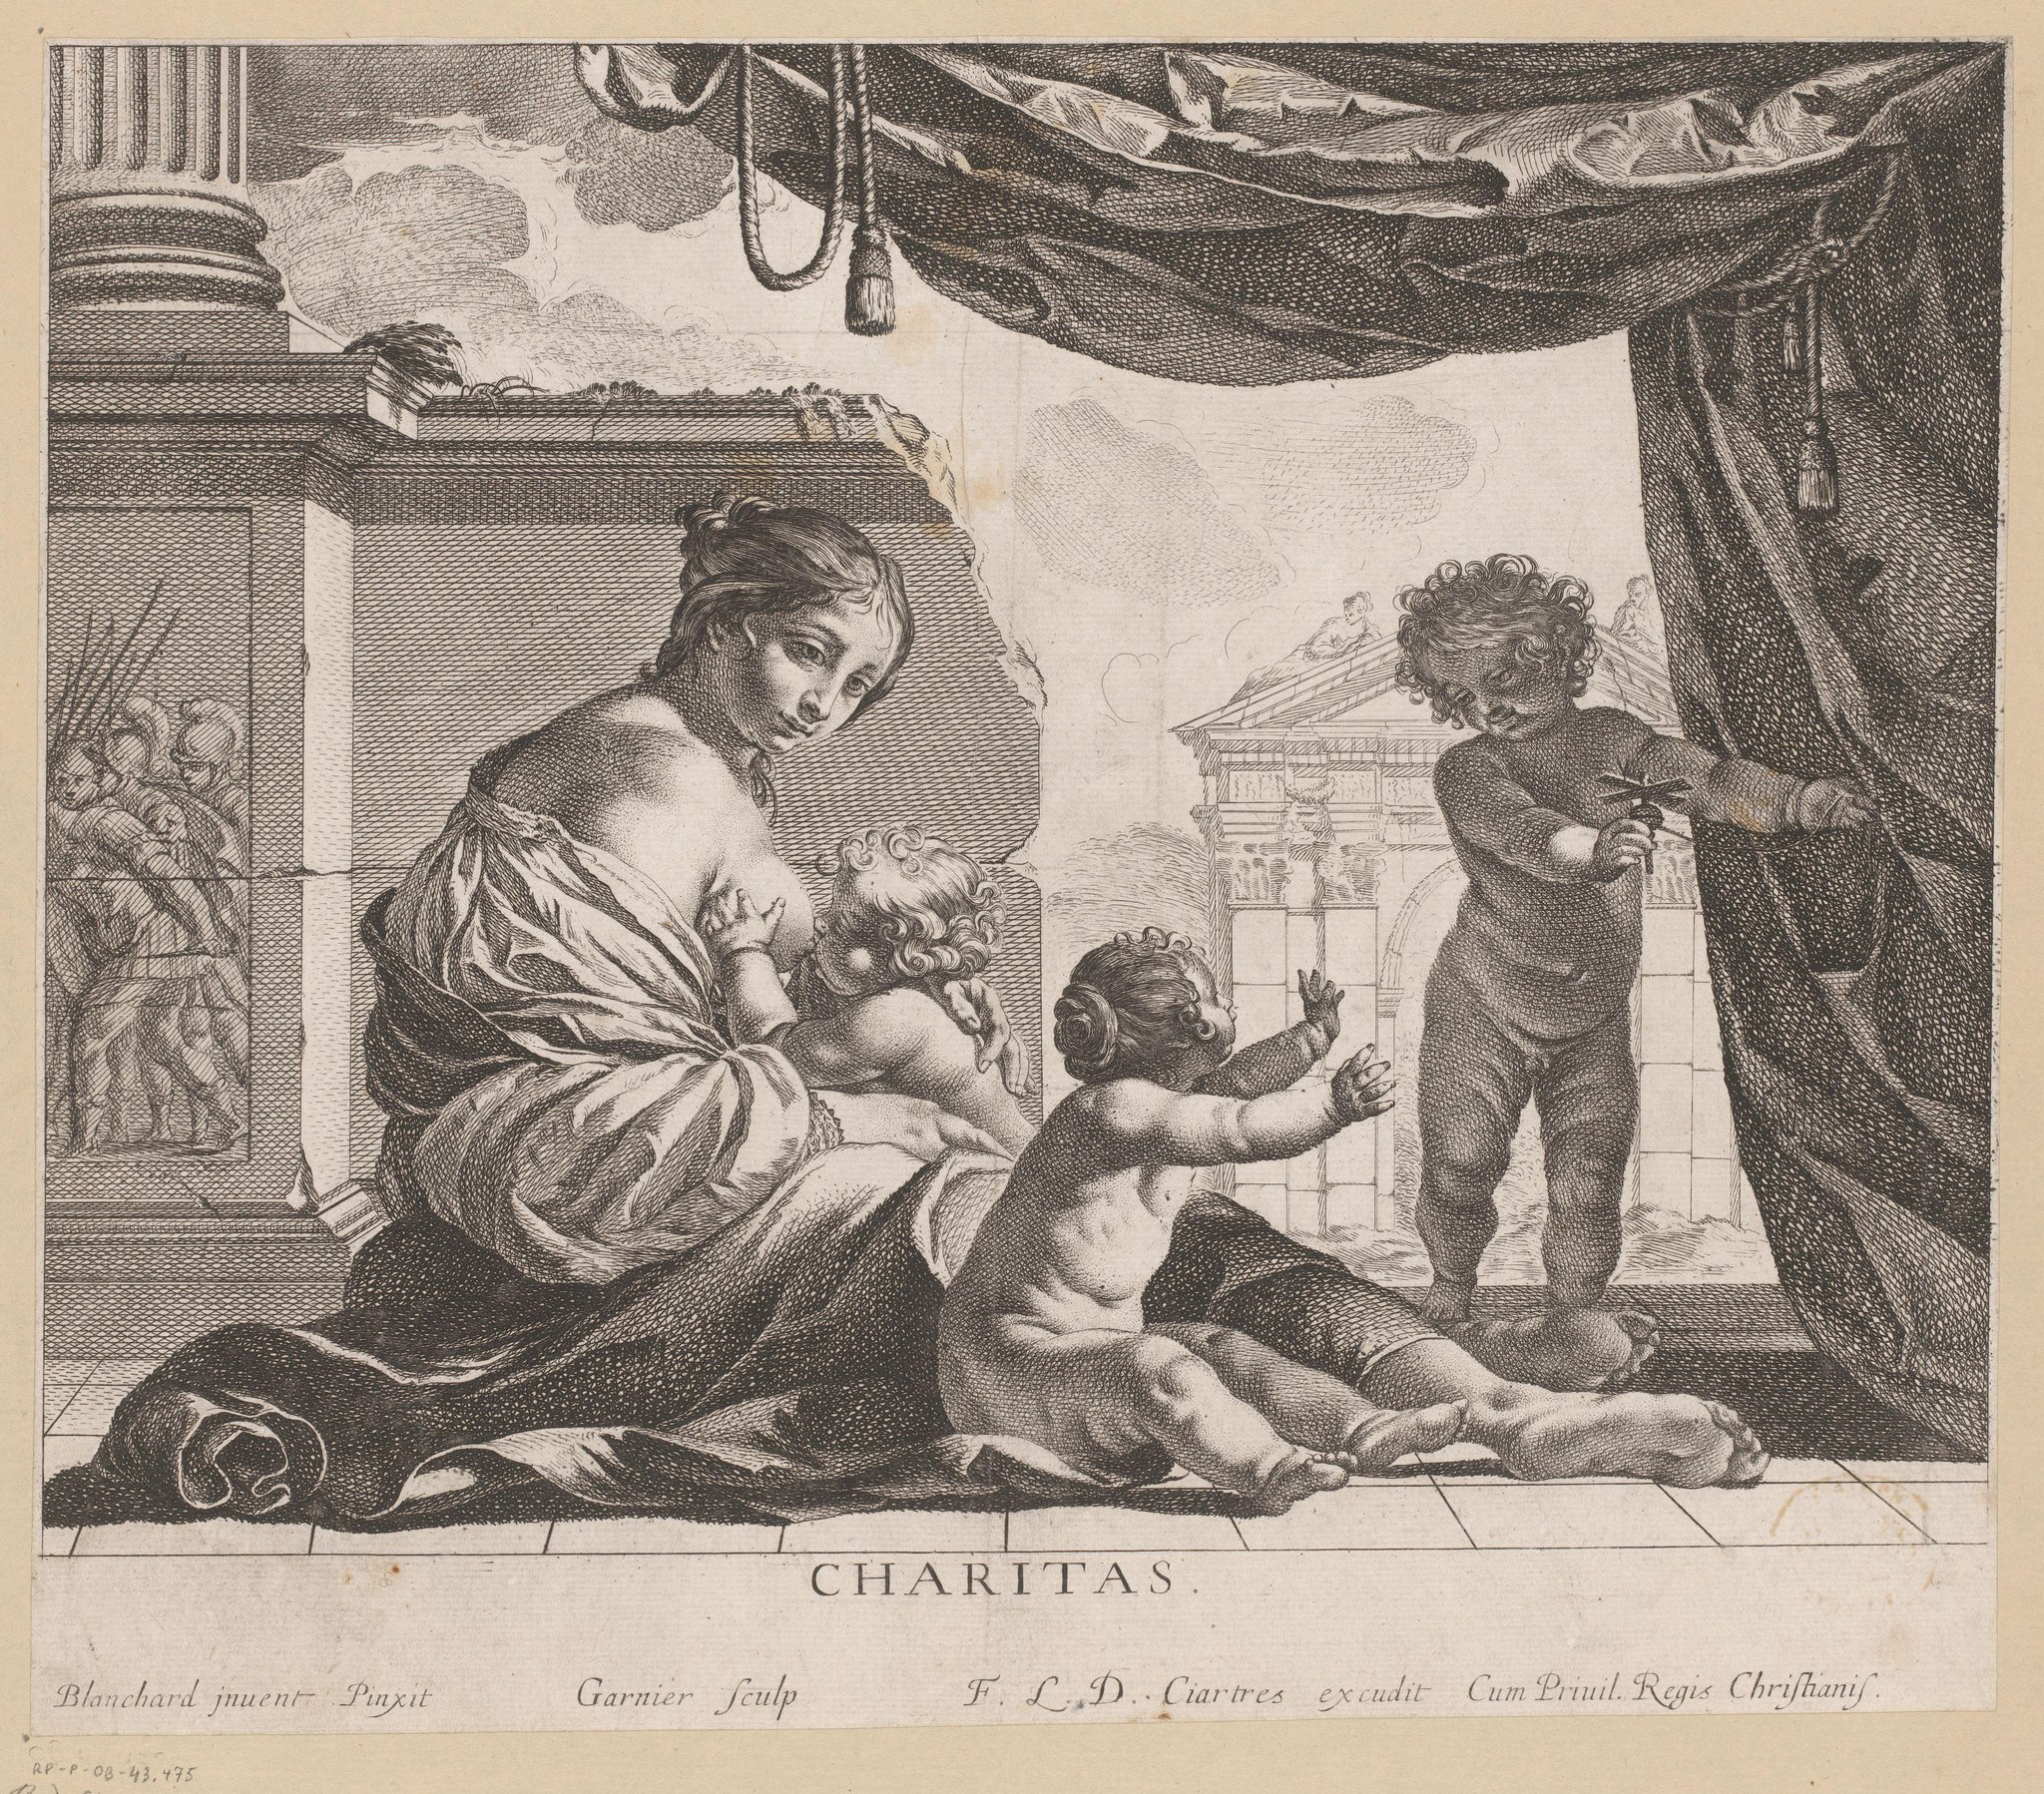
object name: print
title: Charitas.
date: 1636-1694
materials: paper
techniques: engraving, etching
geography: paris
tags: charity, 'caritas'; 'carità' (ripa) ~ one of the three theological virtues, feeding a baby, (playing with) top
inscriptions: collector's mark: Lugt 240